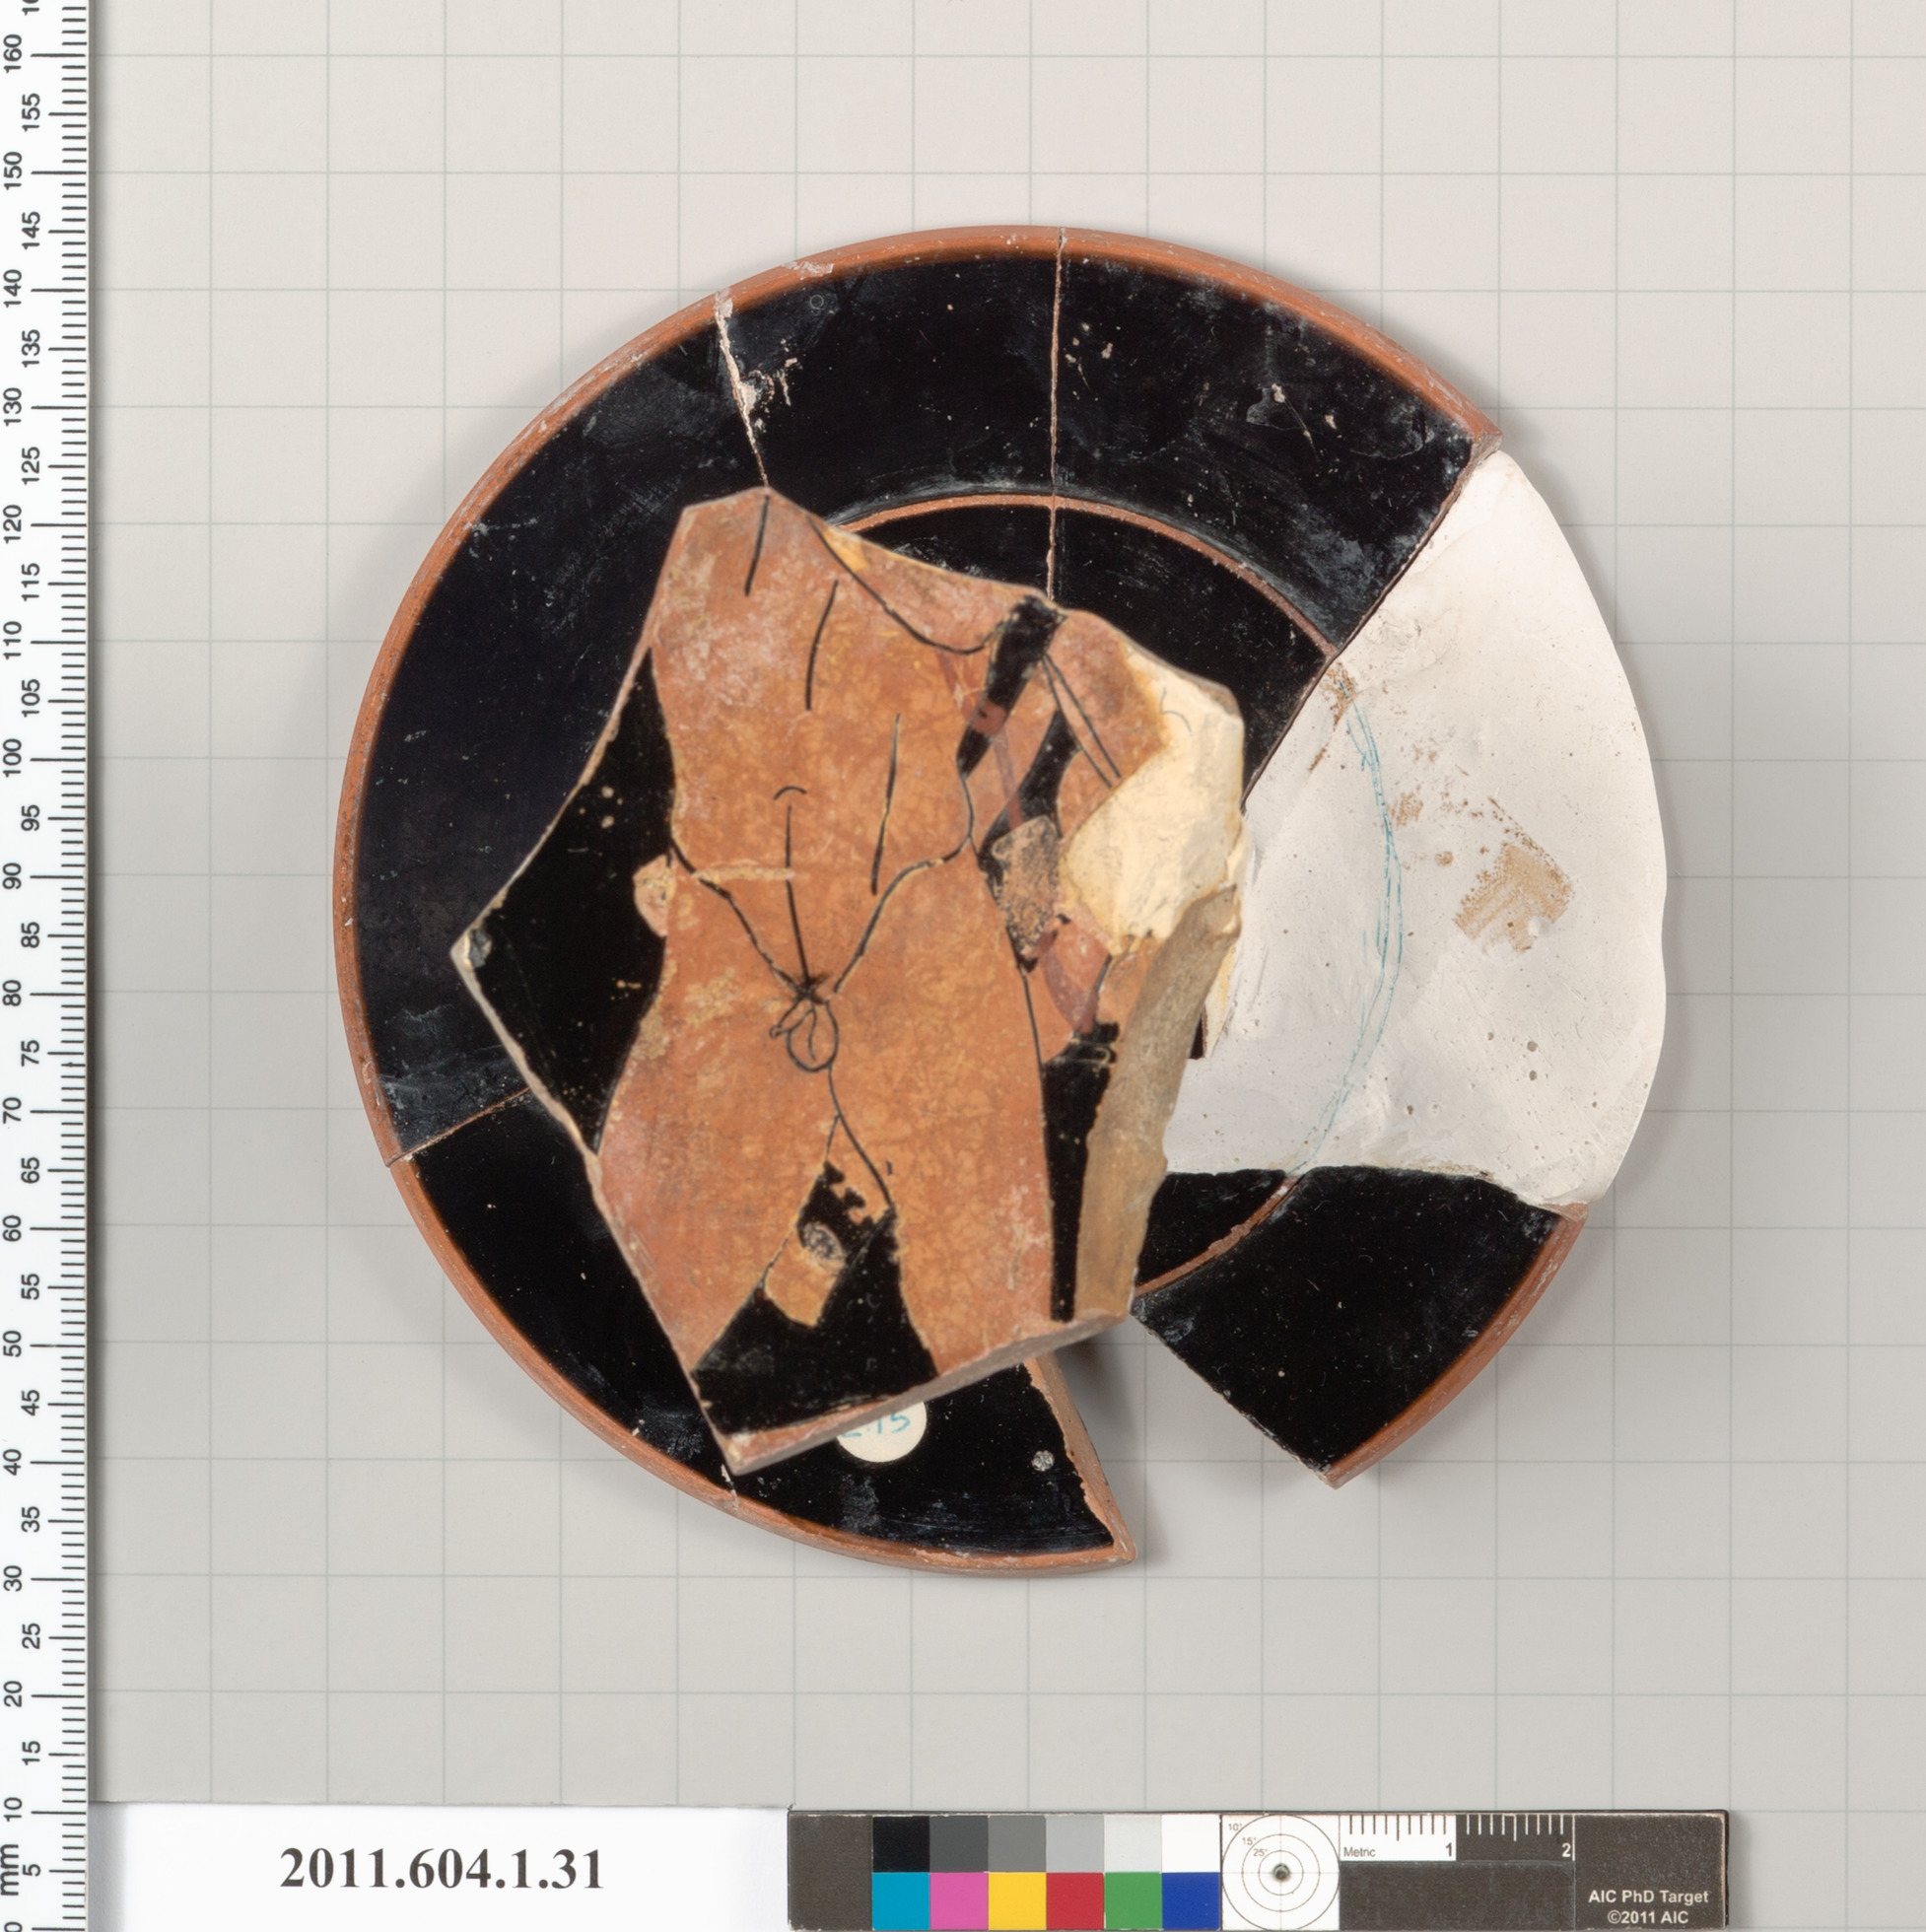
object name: kylix fragment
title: Terracotta fragment of a kylix (drinking cup)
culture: greek, attic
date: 490 BCE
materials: terracotta